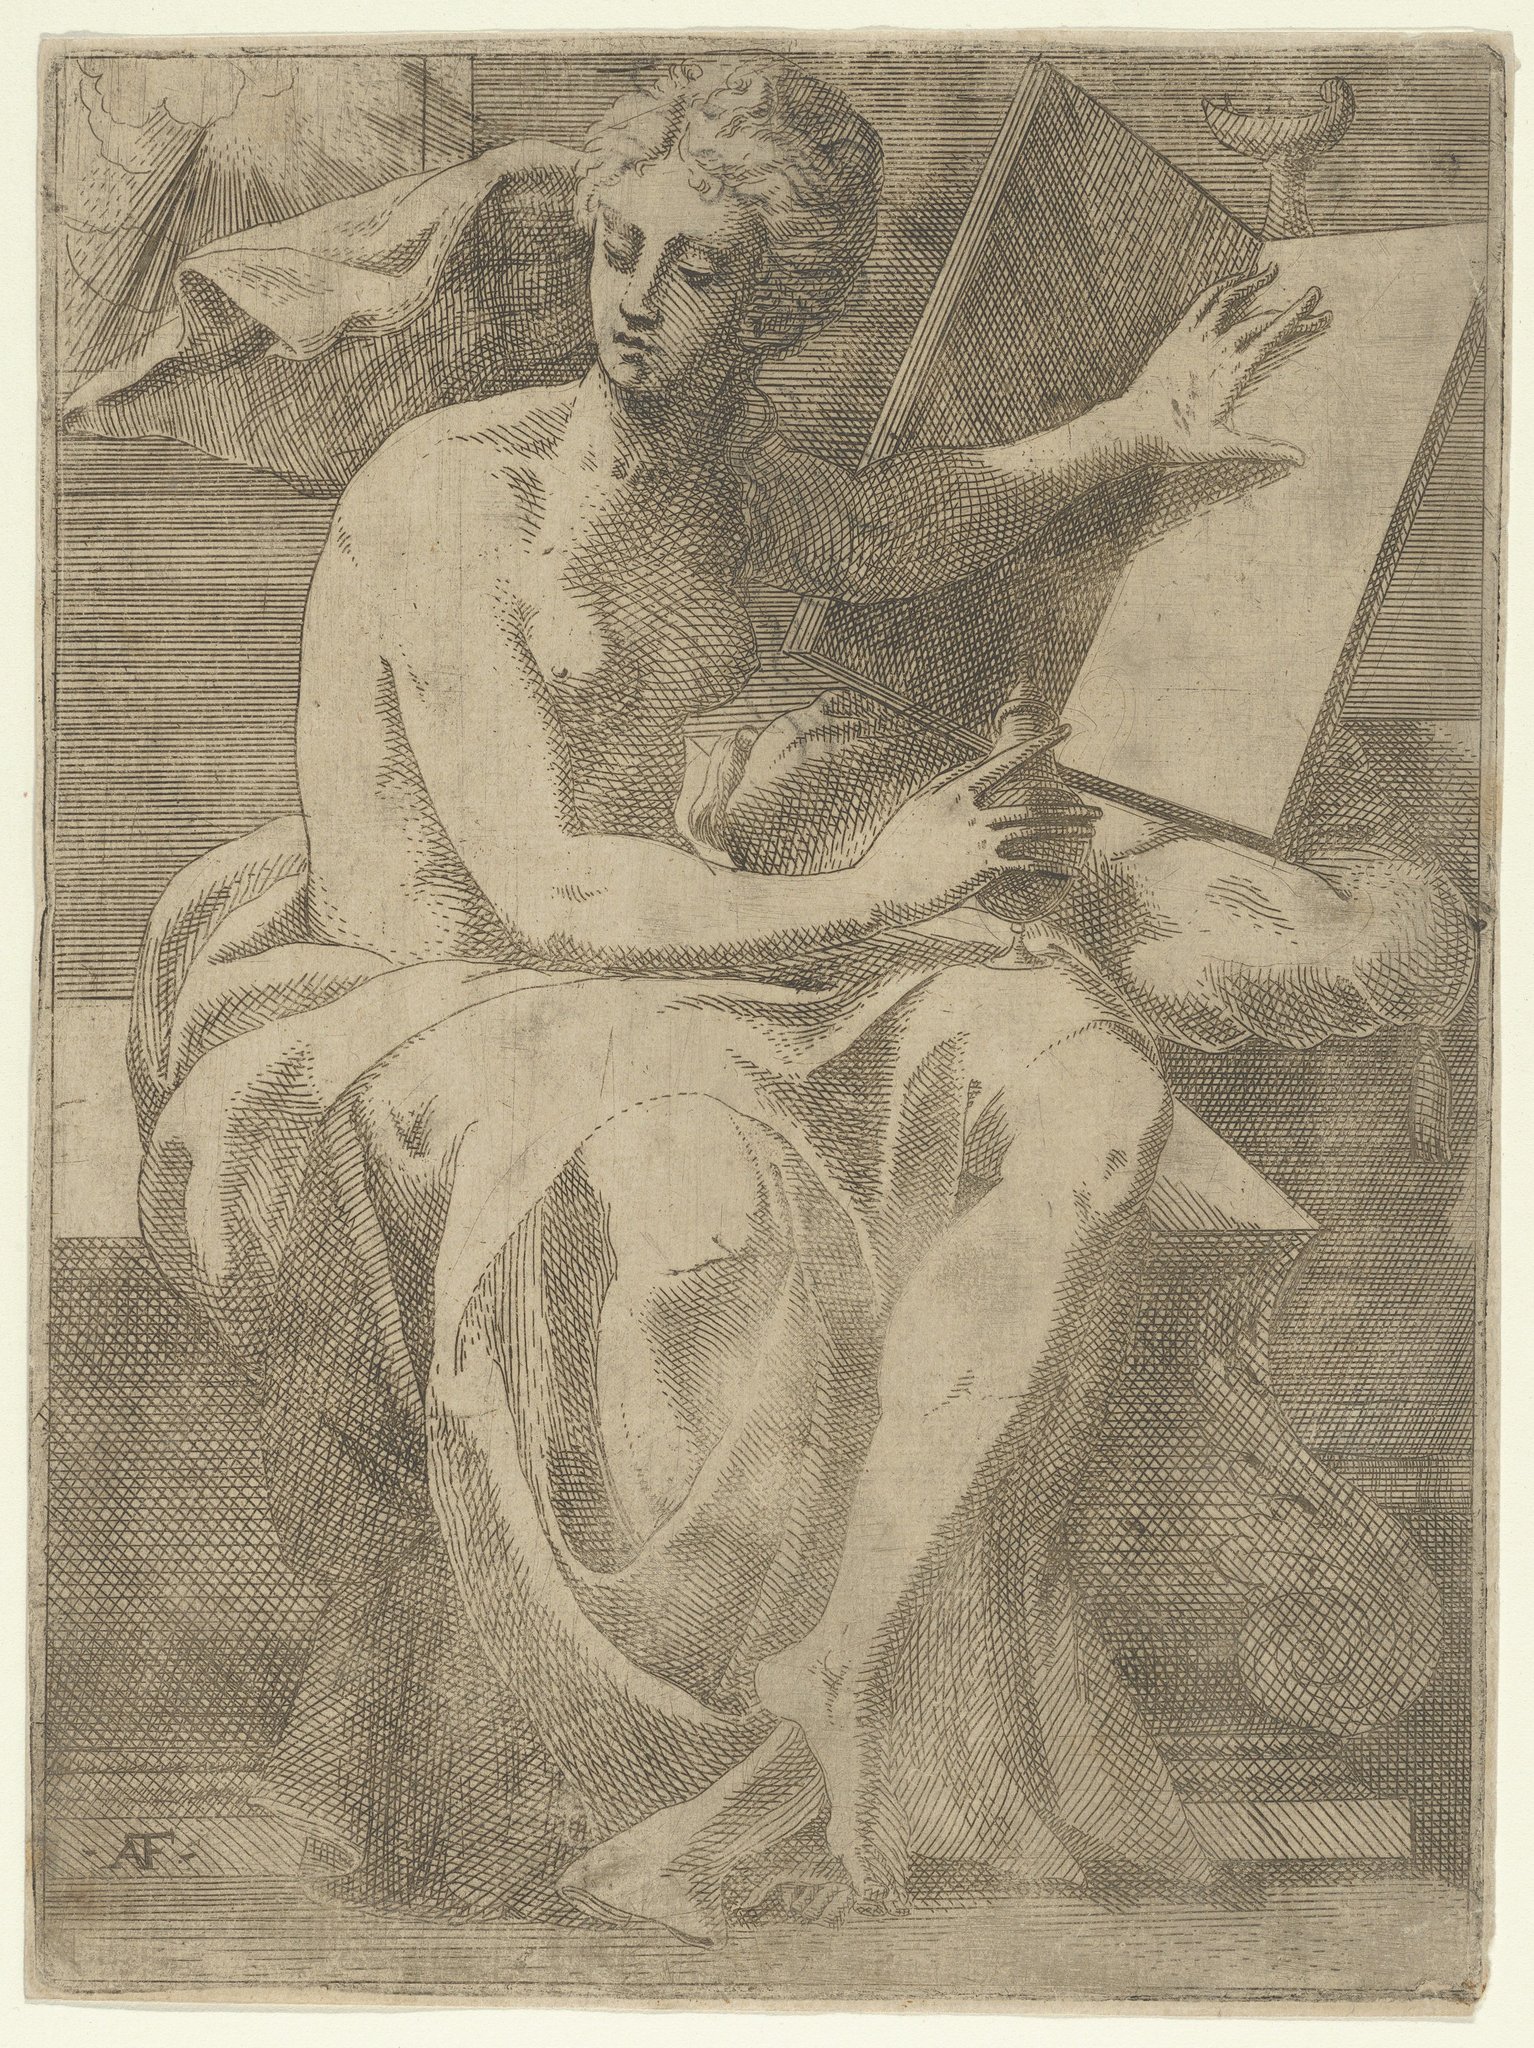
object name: print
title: A Sibyl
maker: antonio fantuzzi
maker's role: artist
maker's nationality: italian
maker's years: 1537-1545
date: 1540-1545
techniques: engraving, etching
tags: books,female nudes